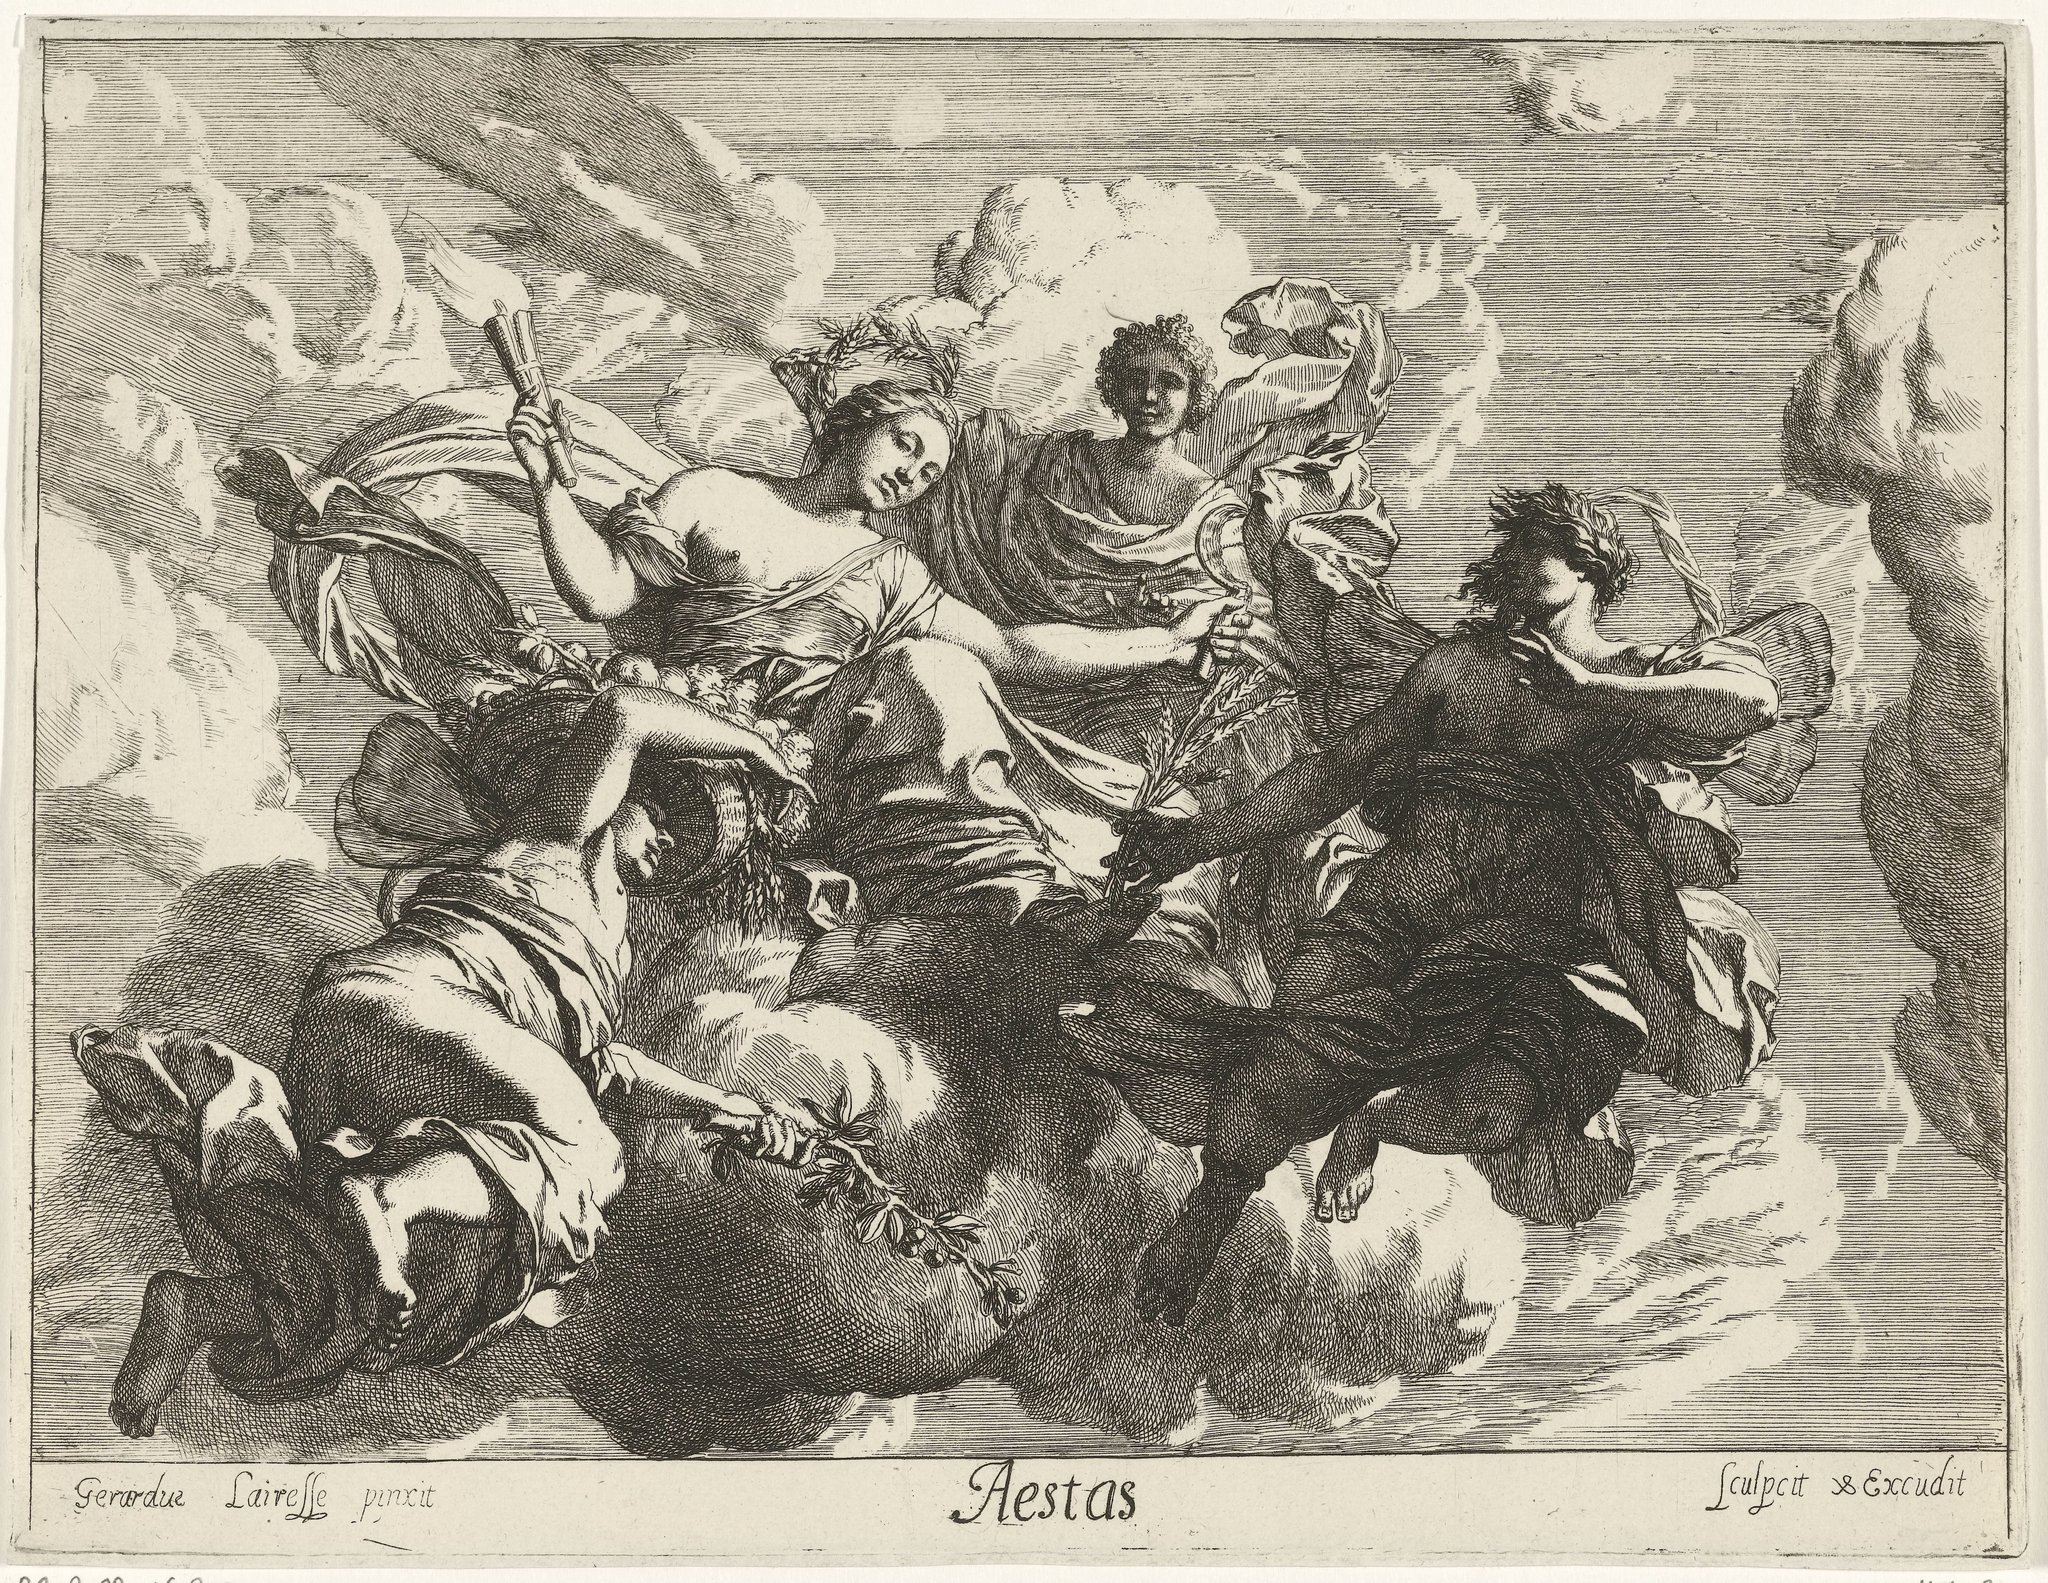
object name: print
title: Aestas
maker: gerard de lairesse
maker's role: draughtsman, painter, print maker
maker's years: 1641-1711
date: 1675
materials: paper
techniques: etching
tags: (story of) ceres (demeter), summer, 'aestas'; 'estate' (ripa)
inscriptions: collector's mark: Lugt 240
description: Ceres zit als personificatie van de zomer op een wolk en is omgeven door drie gepersonifieerde maanden die fruitmanden, olijftakken en graan aandragen. Ceres wordt gekroond met een krans van graan, in haar handen houdt ze een brandende toorts en een sikkel. De prent maakt deel uit van een vierdelige serie prenten over de vier jaargetijden.